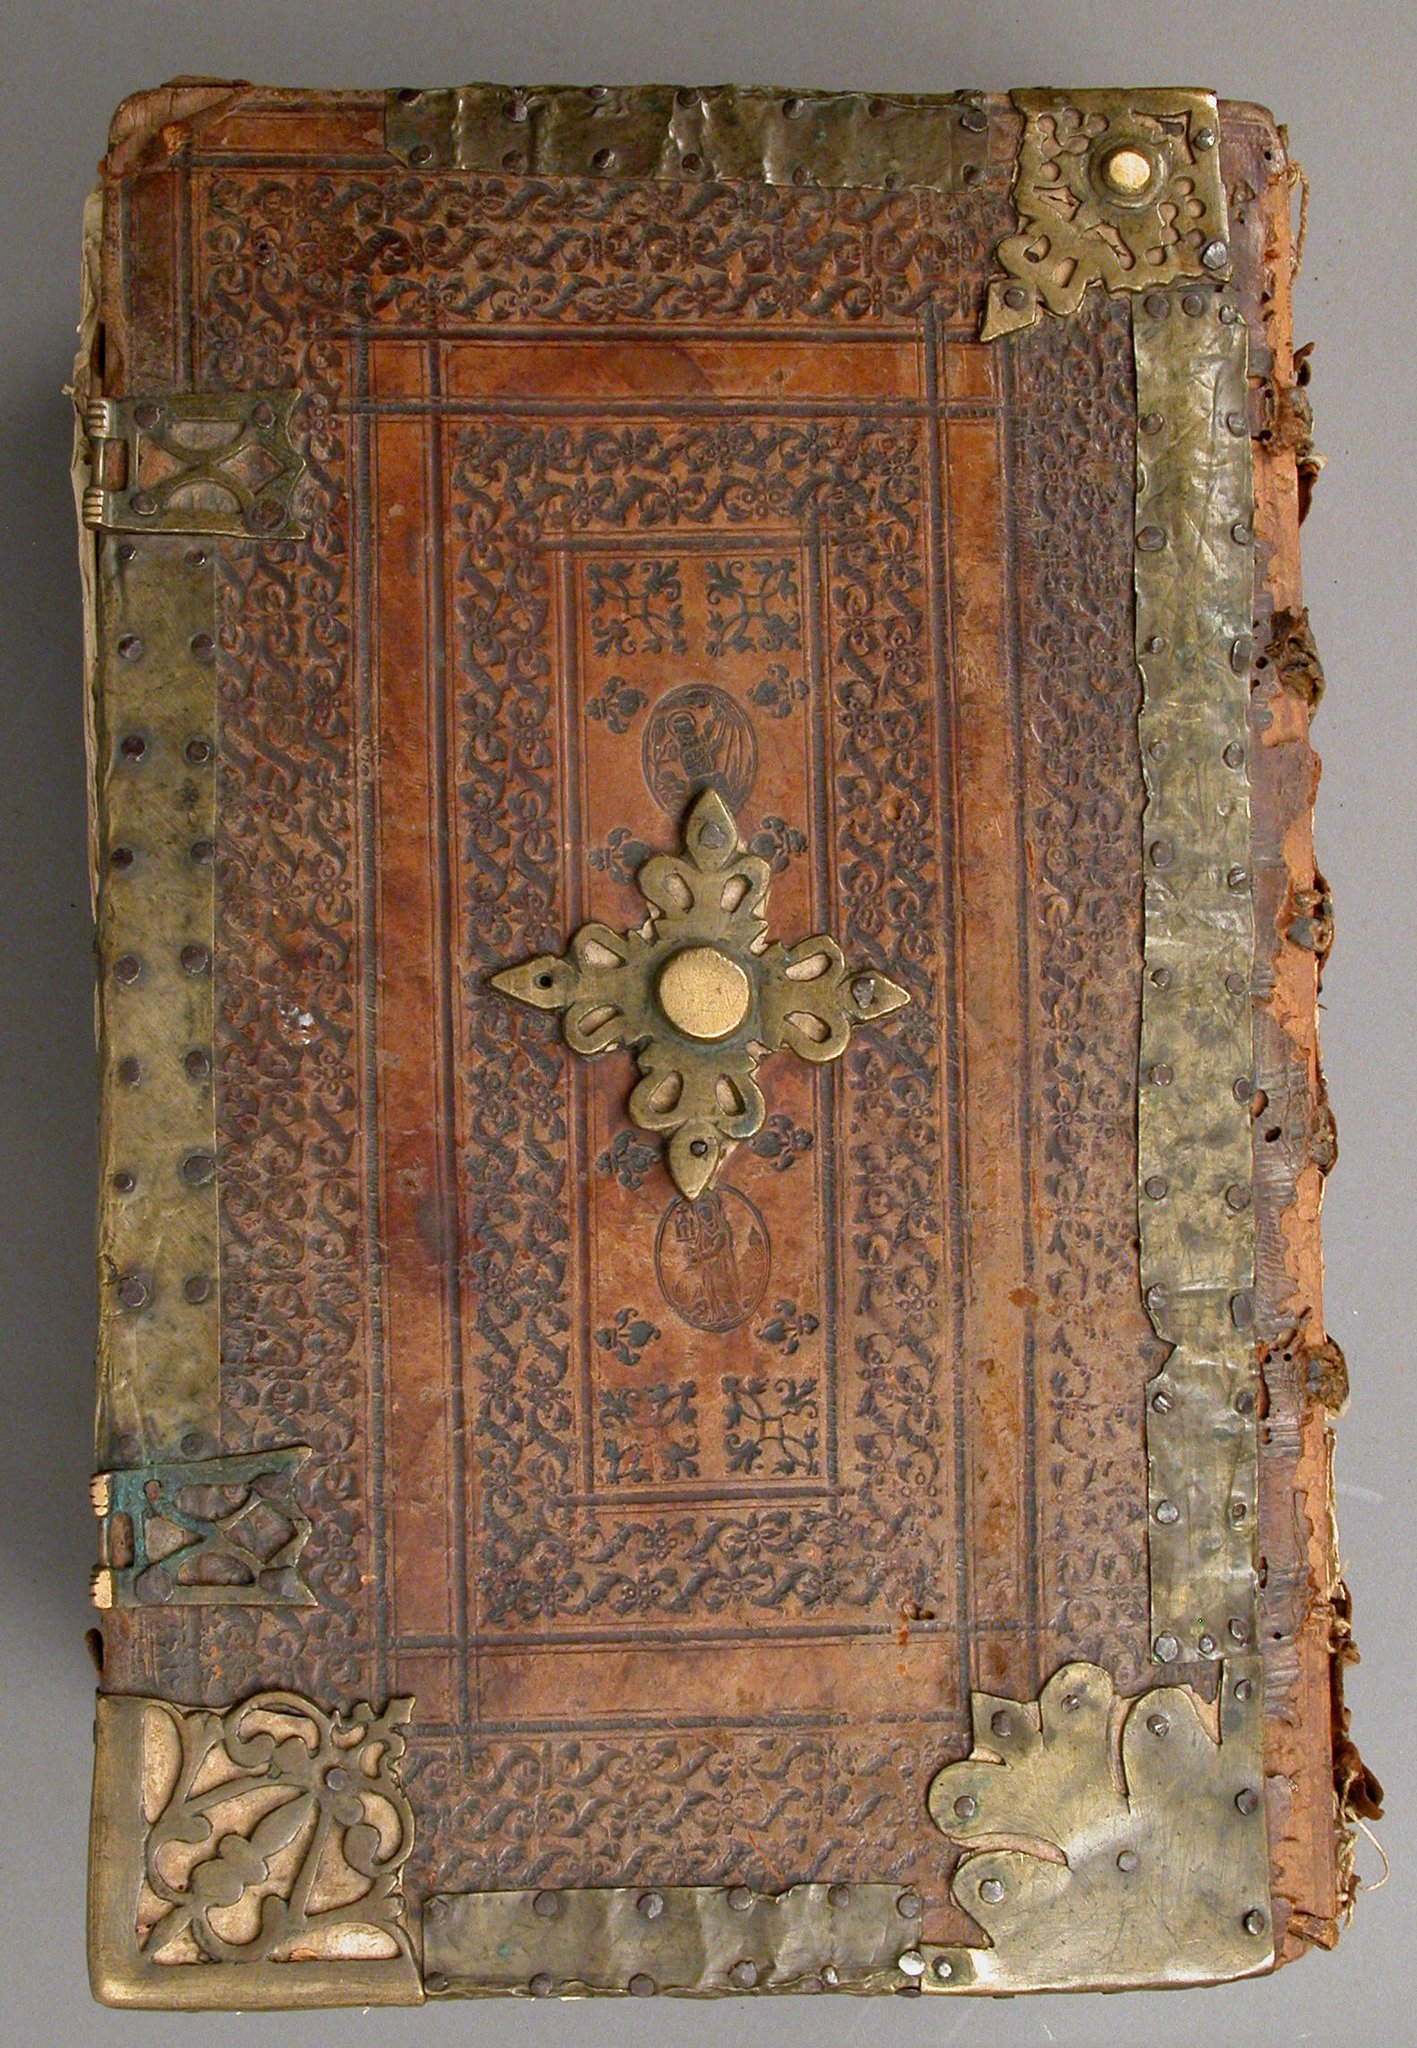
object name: breviary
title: Breviarium Romanum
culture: south netherlandish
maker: jan van keerberghen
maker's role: artist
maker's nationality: dutch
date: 1606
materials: copper alloy, leather, paper, wood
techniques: bookbinding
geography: antwerp